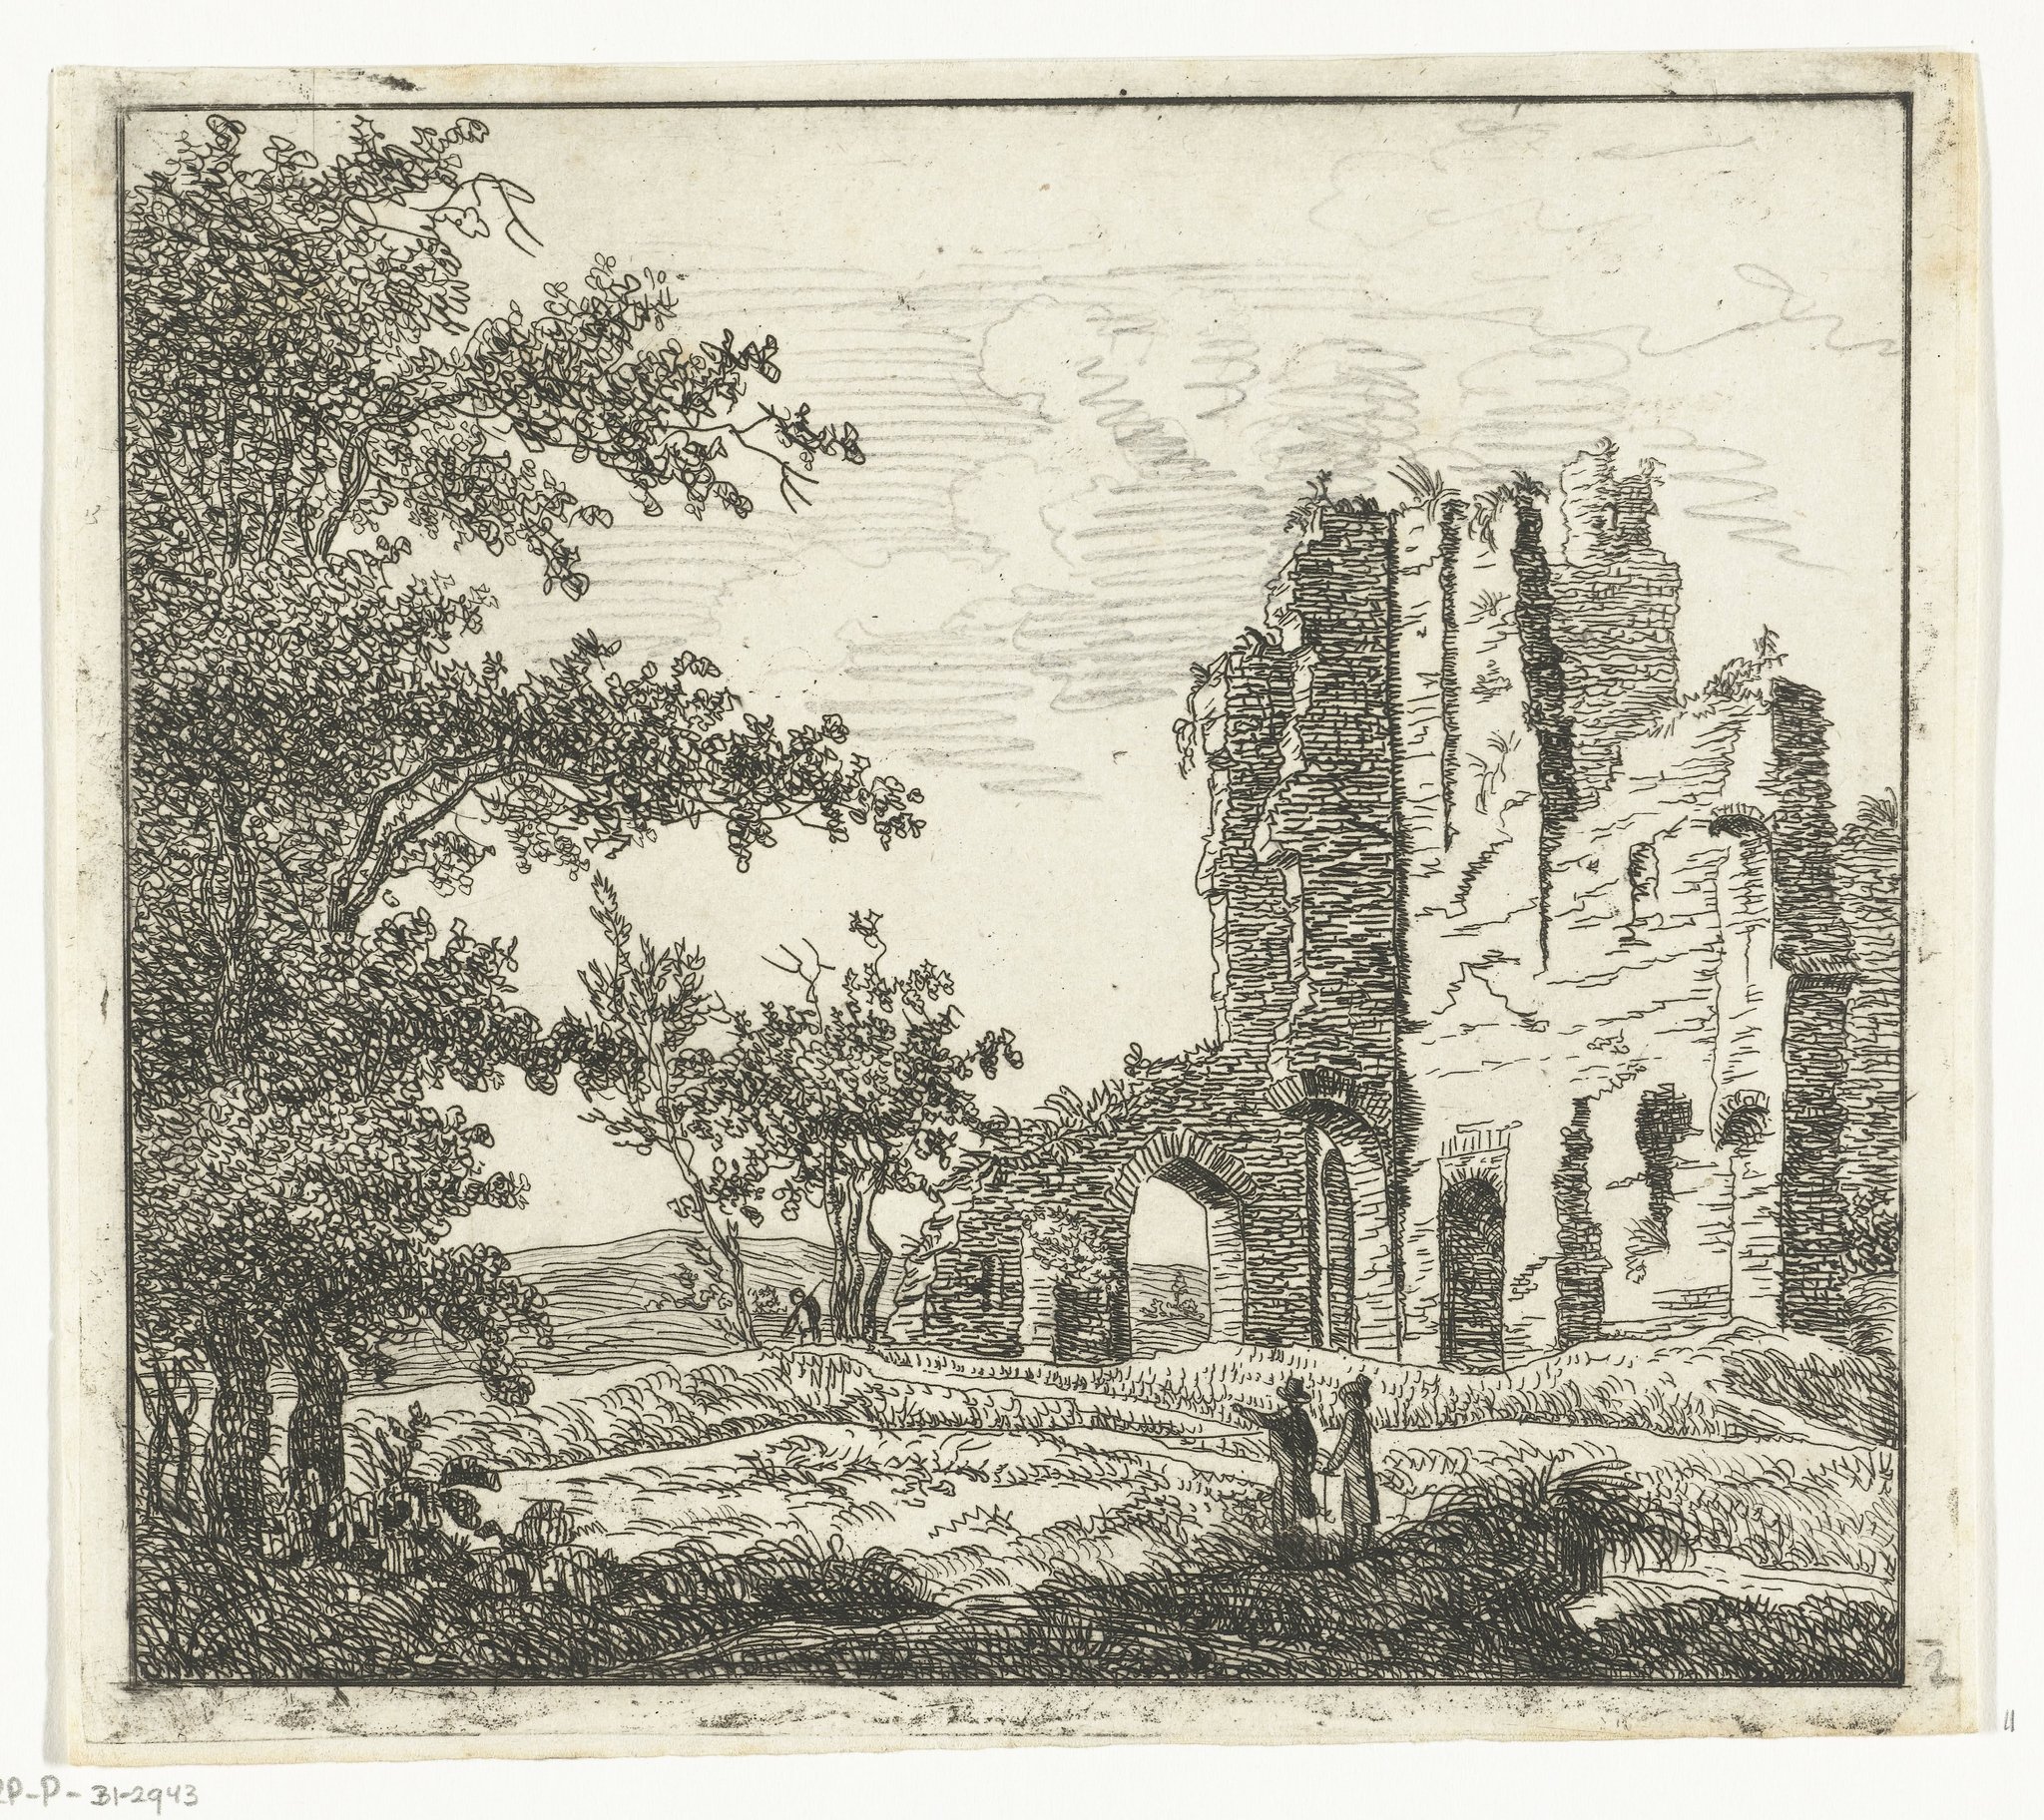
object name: print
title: Ruïne van Brederode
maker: anthonie van den bos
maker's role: draughtsman, print maker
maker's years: 1763-1838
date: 1778-1838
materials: paper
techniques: etching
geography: netherlands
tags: ruin of a dwelling, house, castle, etc.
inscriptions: collector's mark: Lugt 2228